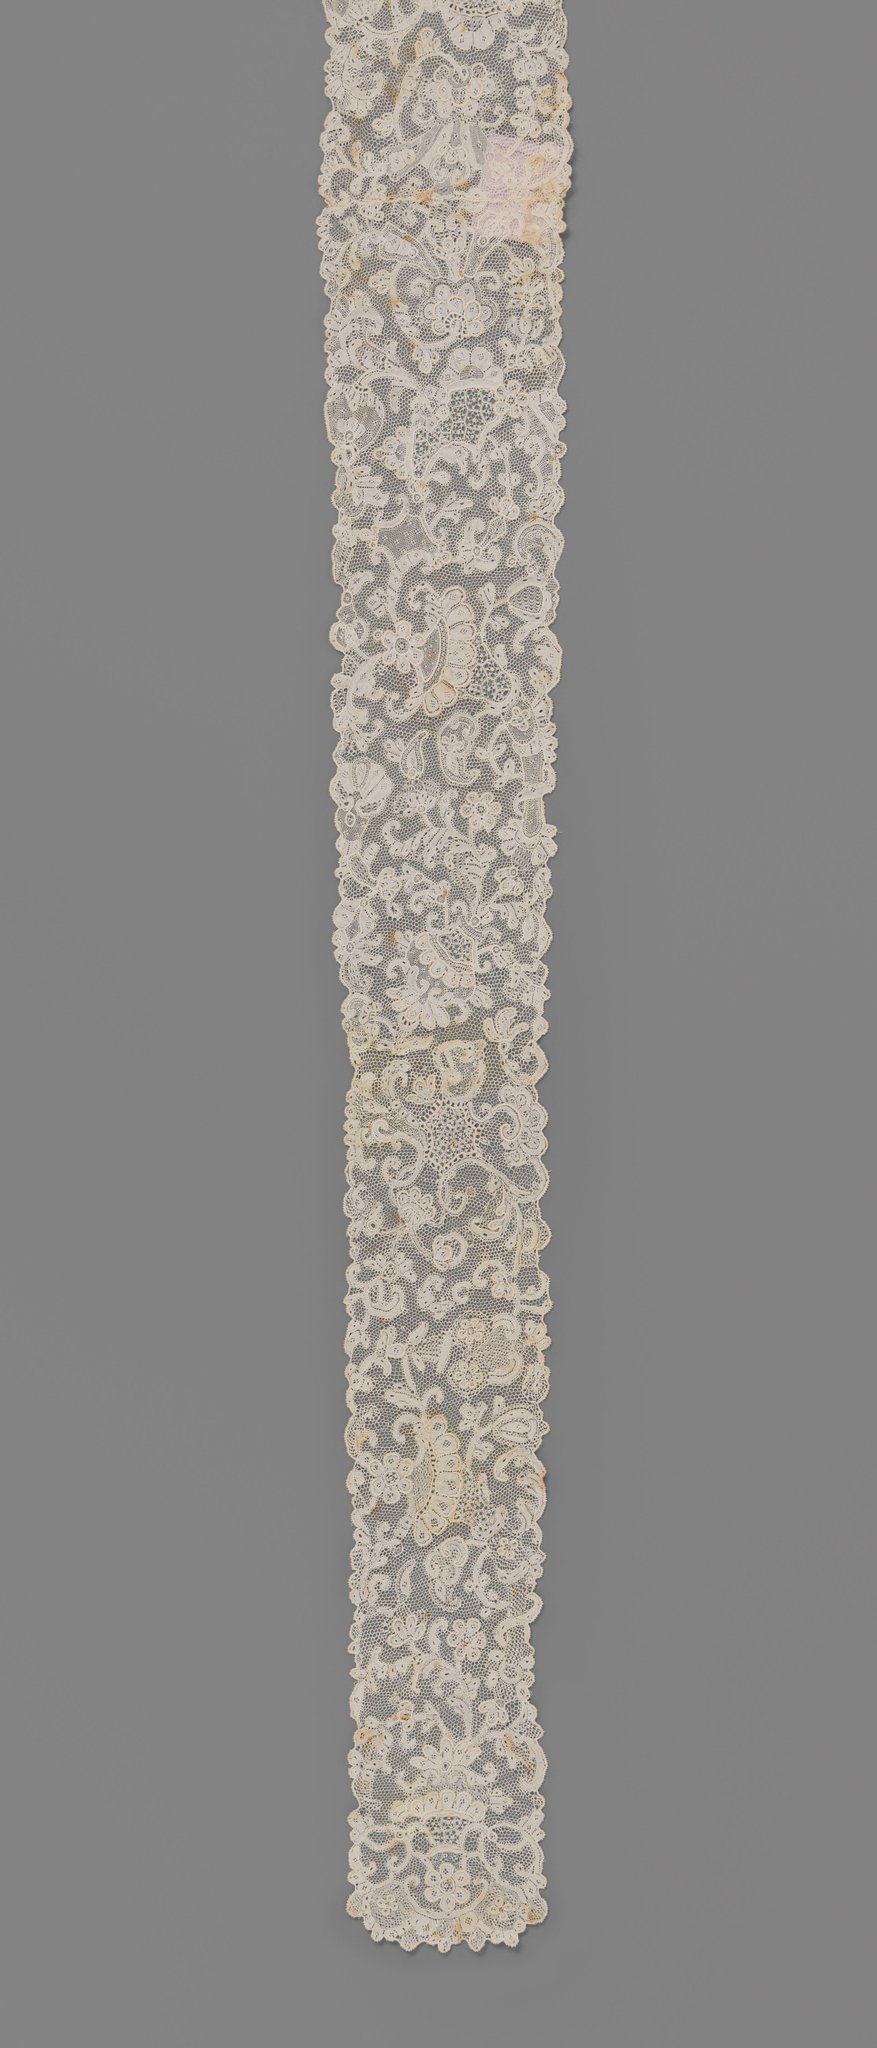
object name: lappet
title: Twee aan elkaar genaaide mutsenslippen van Venise of Burano fin a reséau naaldkant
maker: Anonymous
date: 1700-1750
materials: lace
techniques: lace, needlepoint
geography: italy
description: Twee aan elkaar genaaide mutsenslippen van Italiaanse naaldkant. Het patroon heeft bloemtakken, bloemen en C-voluten. De geschulpte rand is afgezet met picots.